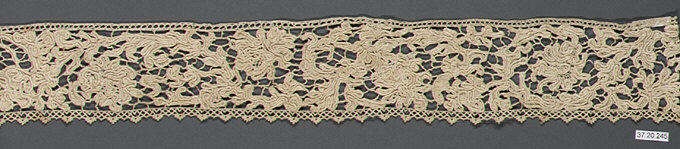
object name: border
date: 1601-1700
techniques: lace